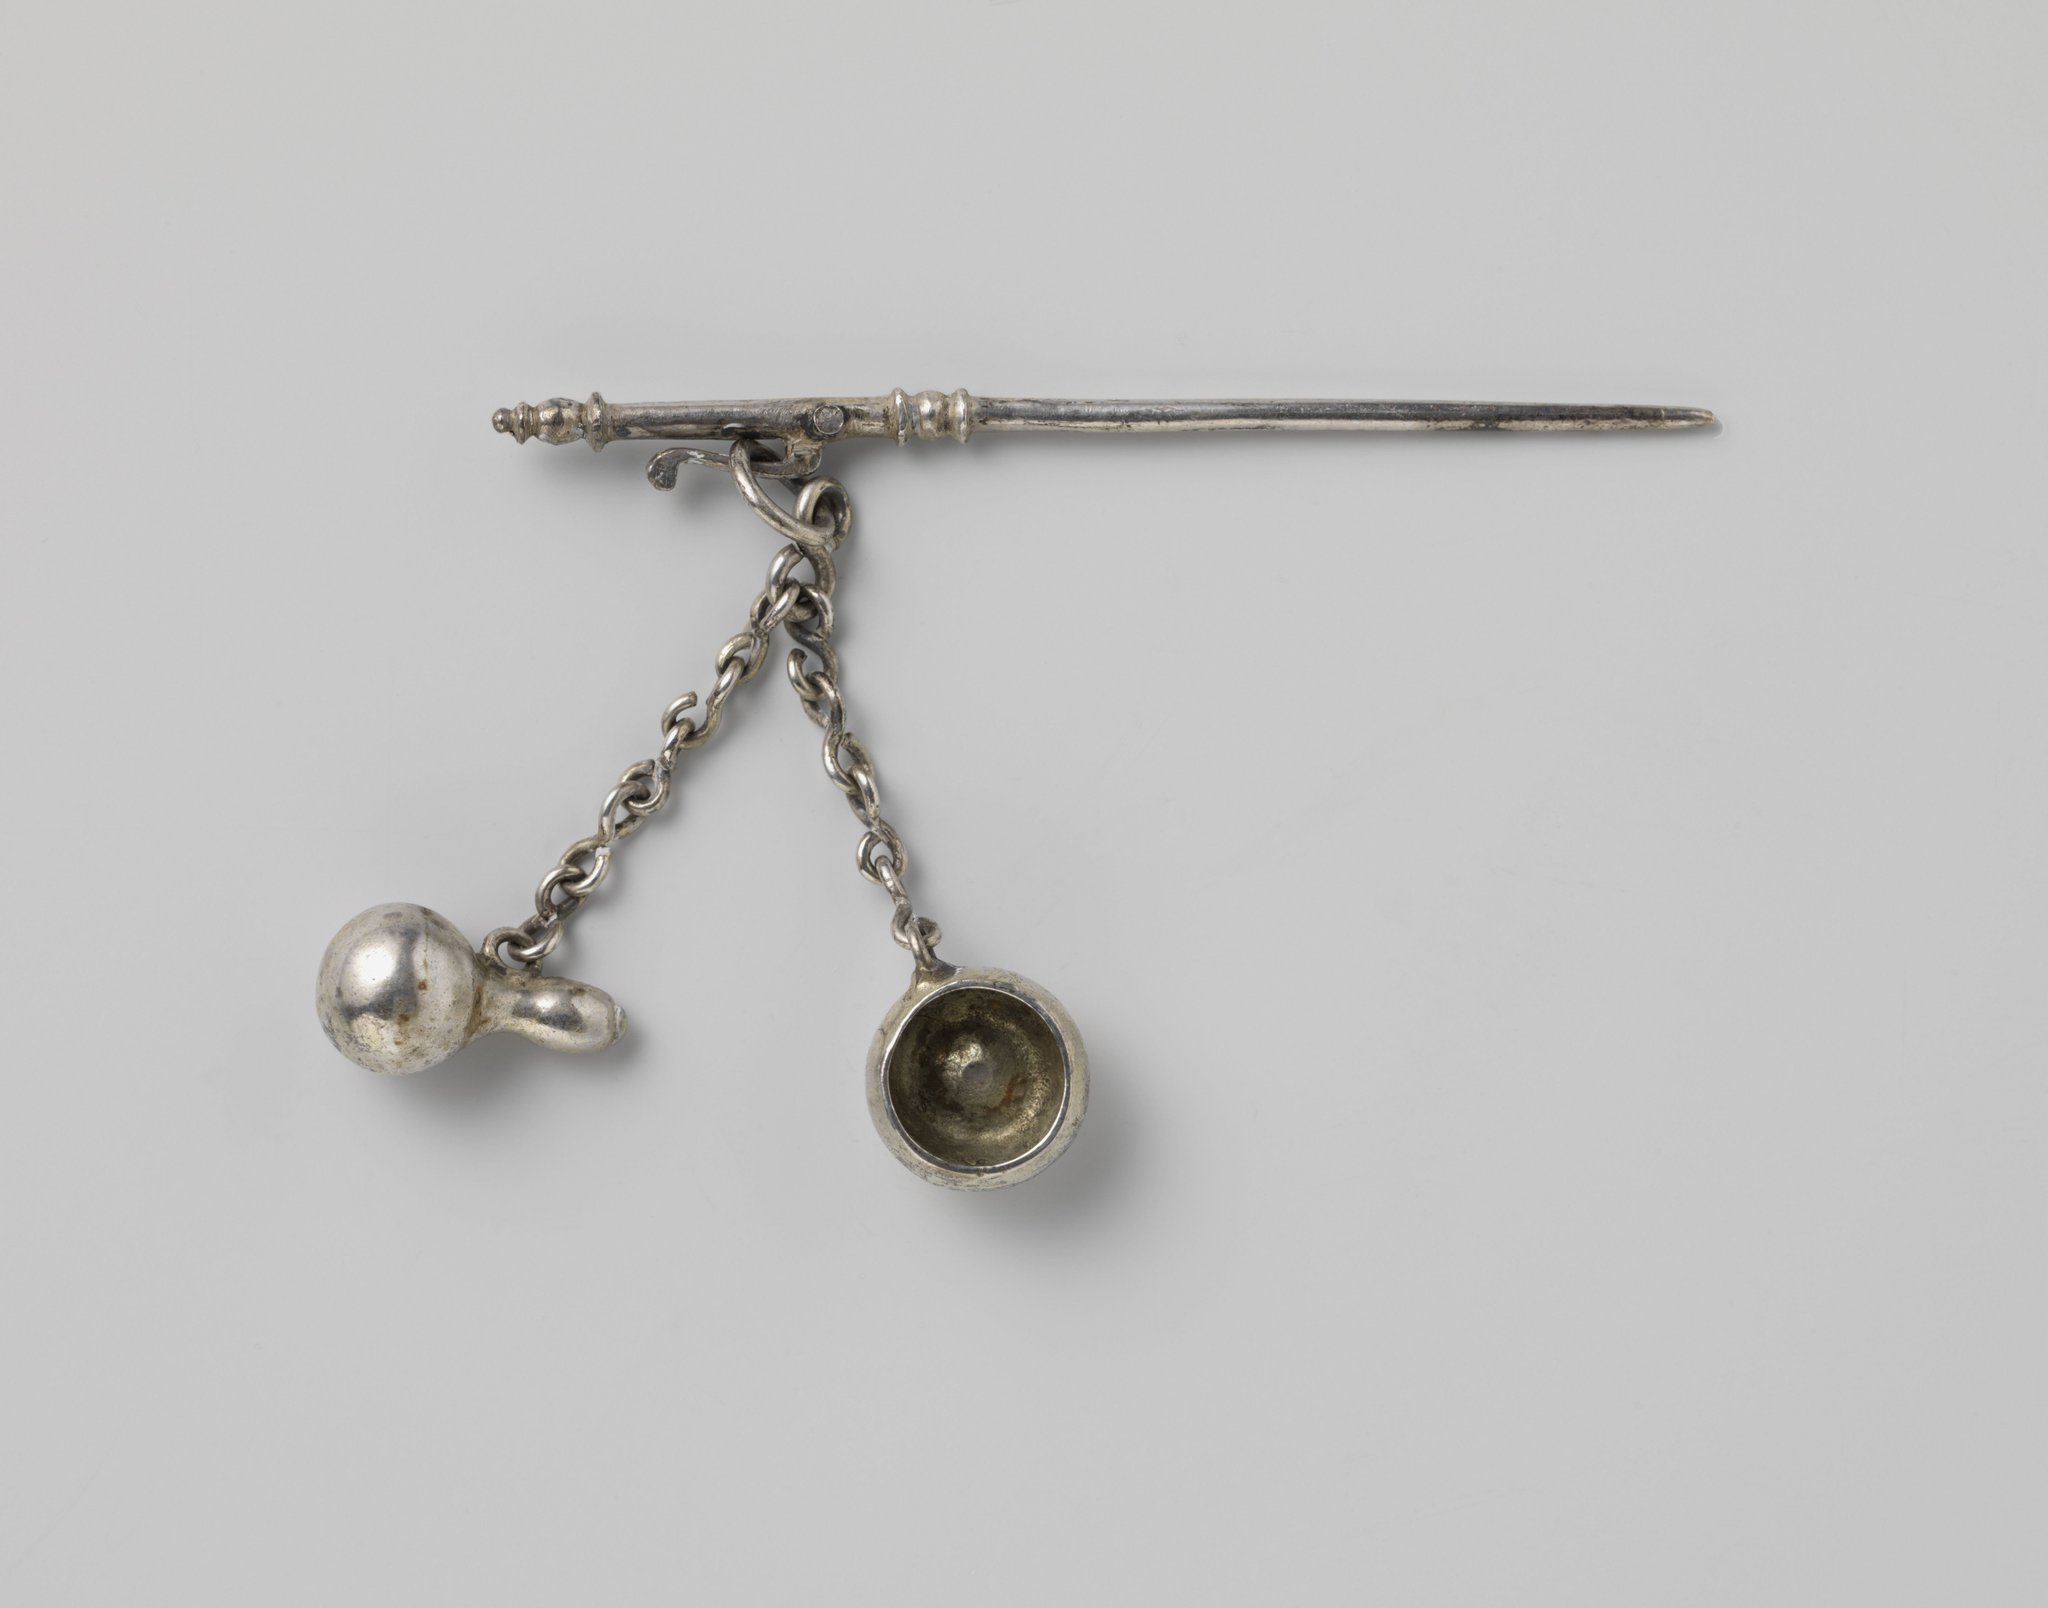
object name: pin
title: Geuzendraagteken, speld met napje en kalebasje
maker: Anonymous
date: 1566-1600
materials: brass, gold, silver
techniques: forging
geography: netherlands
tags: verbond der edelen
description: When in 1566 several hundred Dutch noblemen petitioned the Spanish authorities for greater tolerance in matters of religion, they were ridiculed as 'gueux': beggars. In response, they took the French name 'gueux' (vulgarised to 'geuzen') as a symbol of honour and wore a beggar's badge on their clothes. These were tokens that town authorities gave to beggars to show that they were legally allowed to beg. The crescent shape of the medals and the text around the edge 'Better Turkish than Papish' had several connotations. Turks had a reputation for cruelty; but they were also known for their tolerance to other religions. Moreover, the Islamic Turkish Empire was at war with Catholic Spain. Apart from badges, the Geuzen also carried small wooden begging bowls and flasks, reminiscent of the pilgrims who lived by begging.